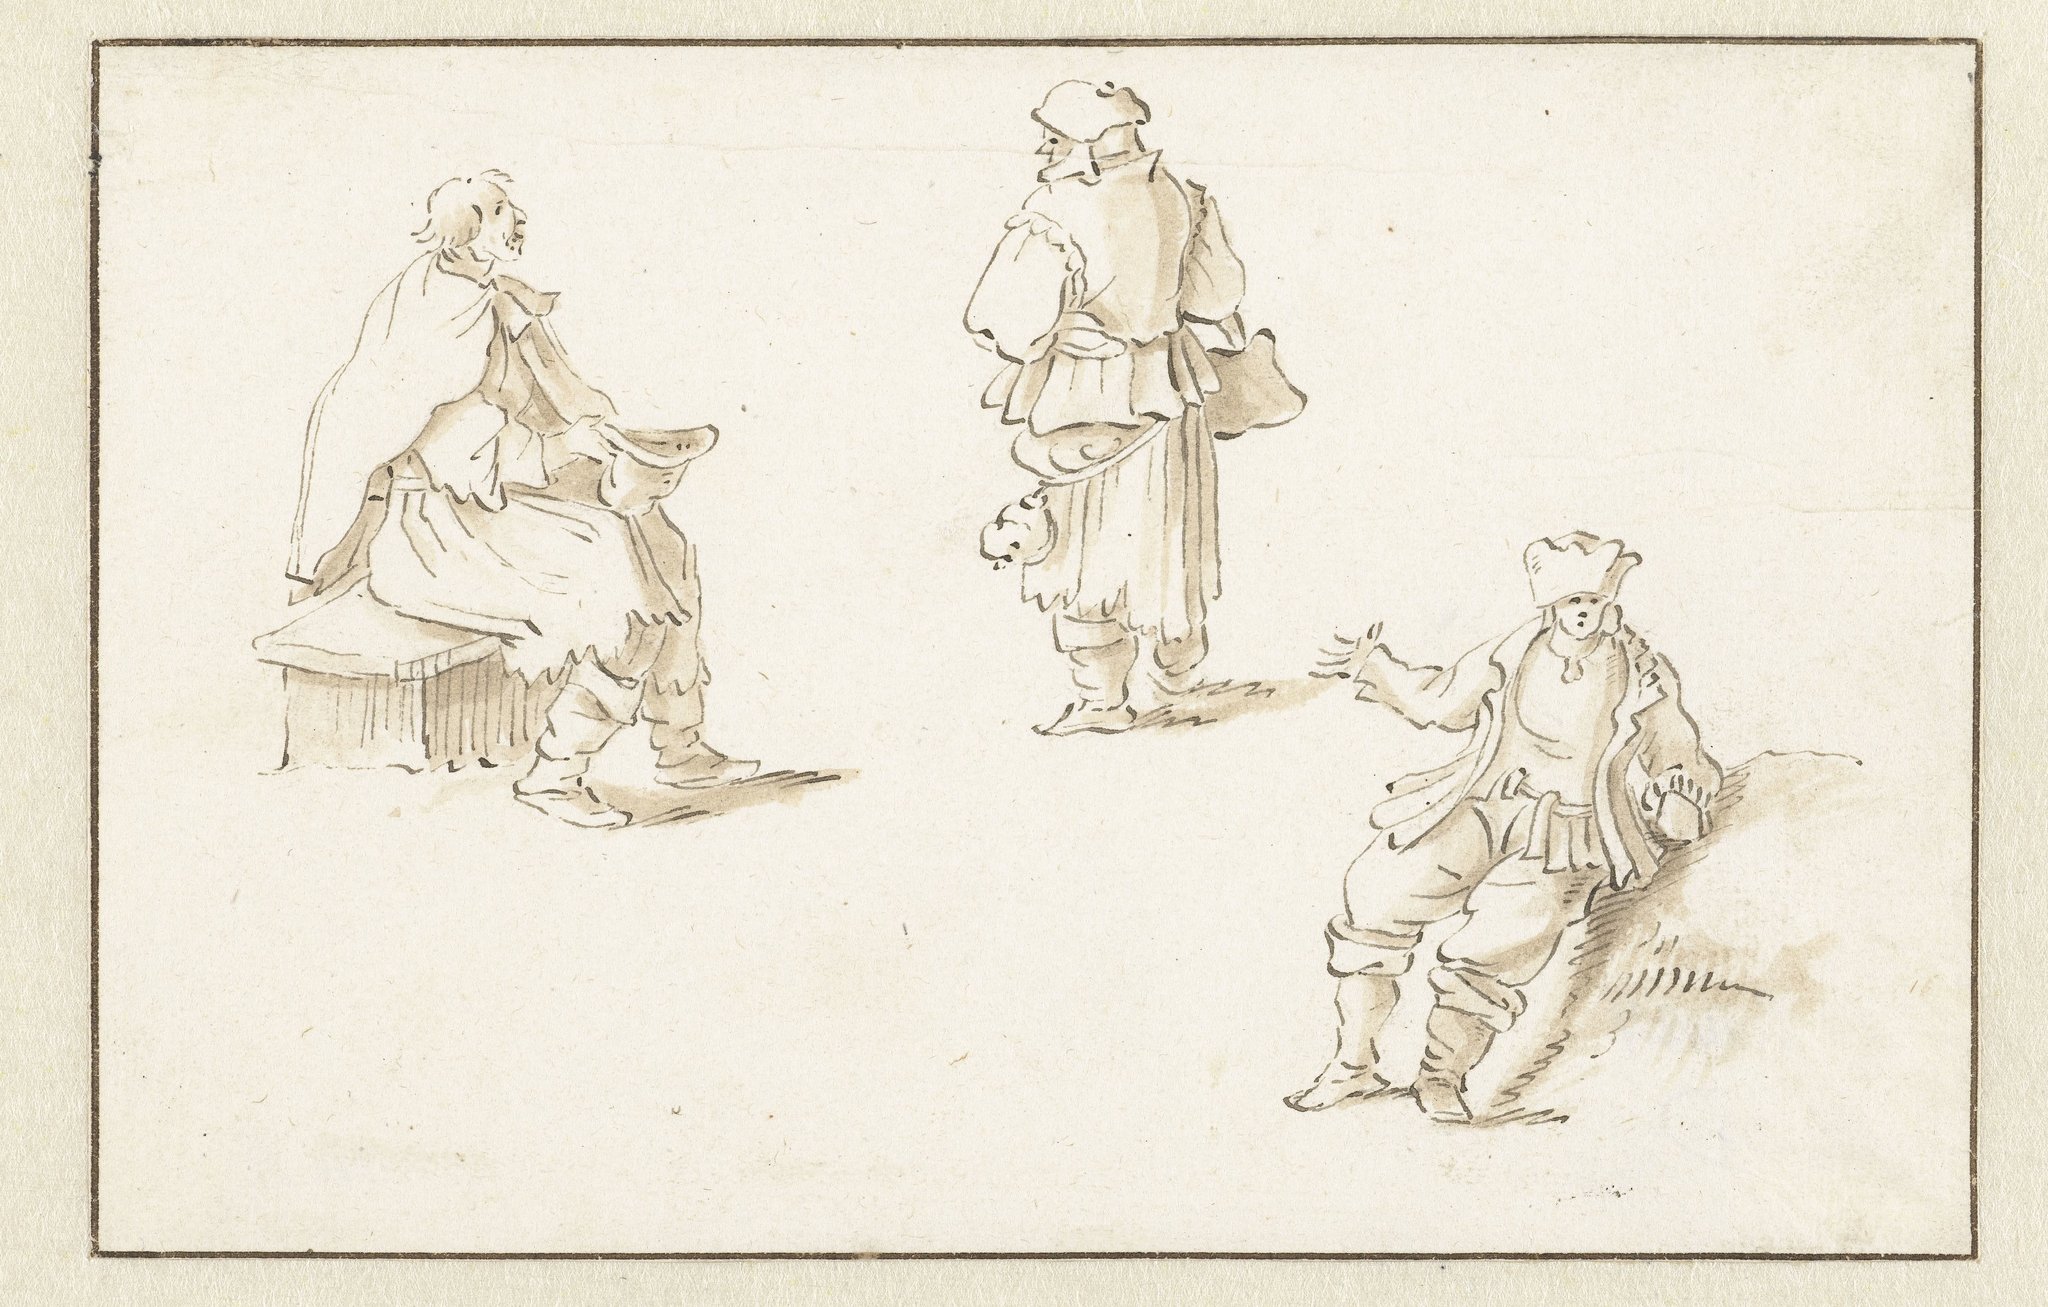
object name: drawing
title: Twee zittende mannen en een staande man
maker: herman saftleven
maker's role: draughtsman, painter, print maker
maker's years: 1609-1685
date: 1619-1685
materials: ink, paper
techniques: brush, pen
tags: standing figure, sitting figure